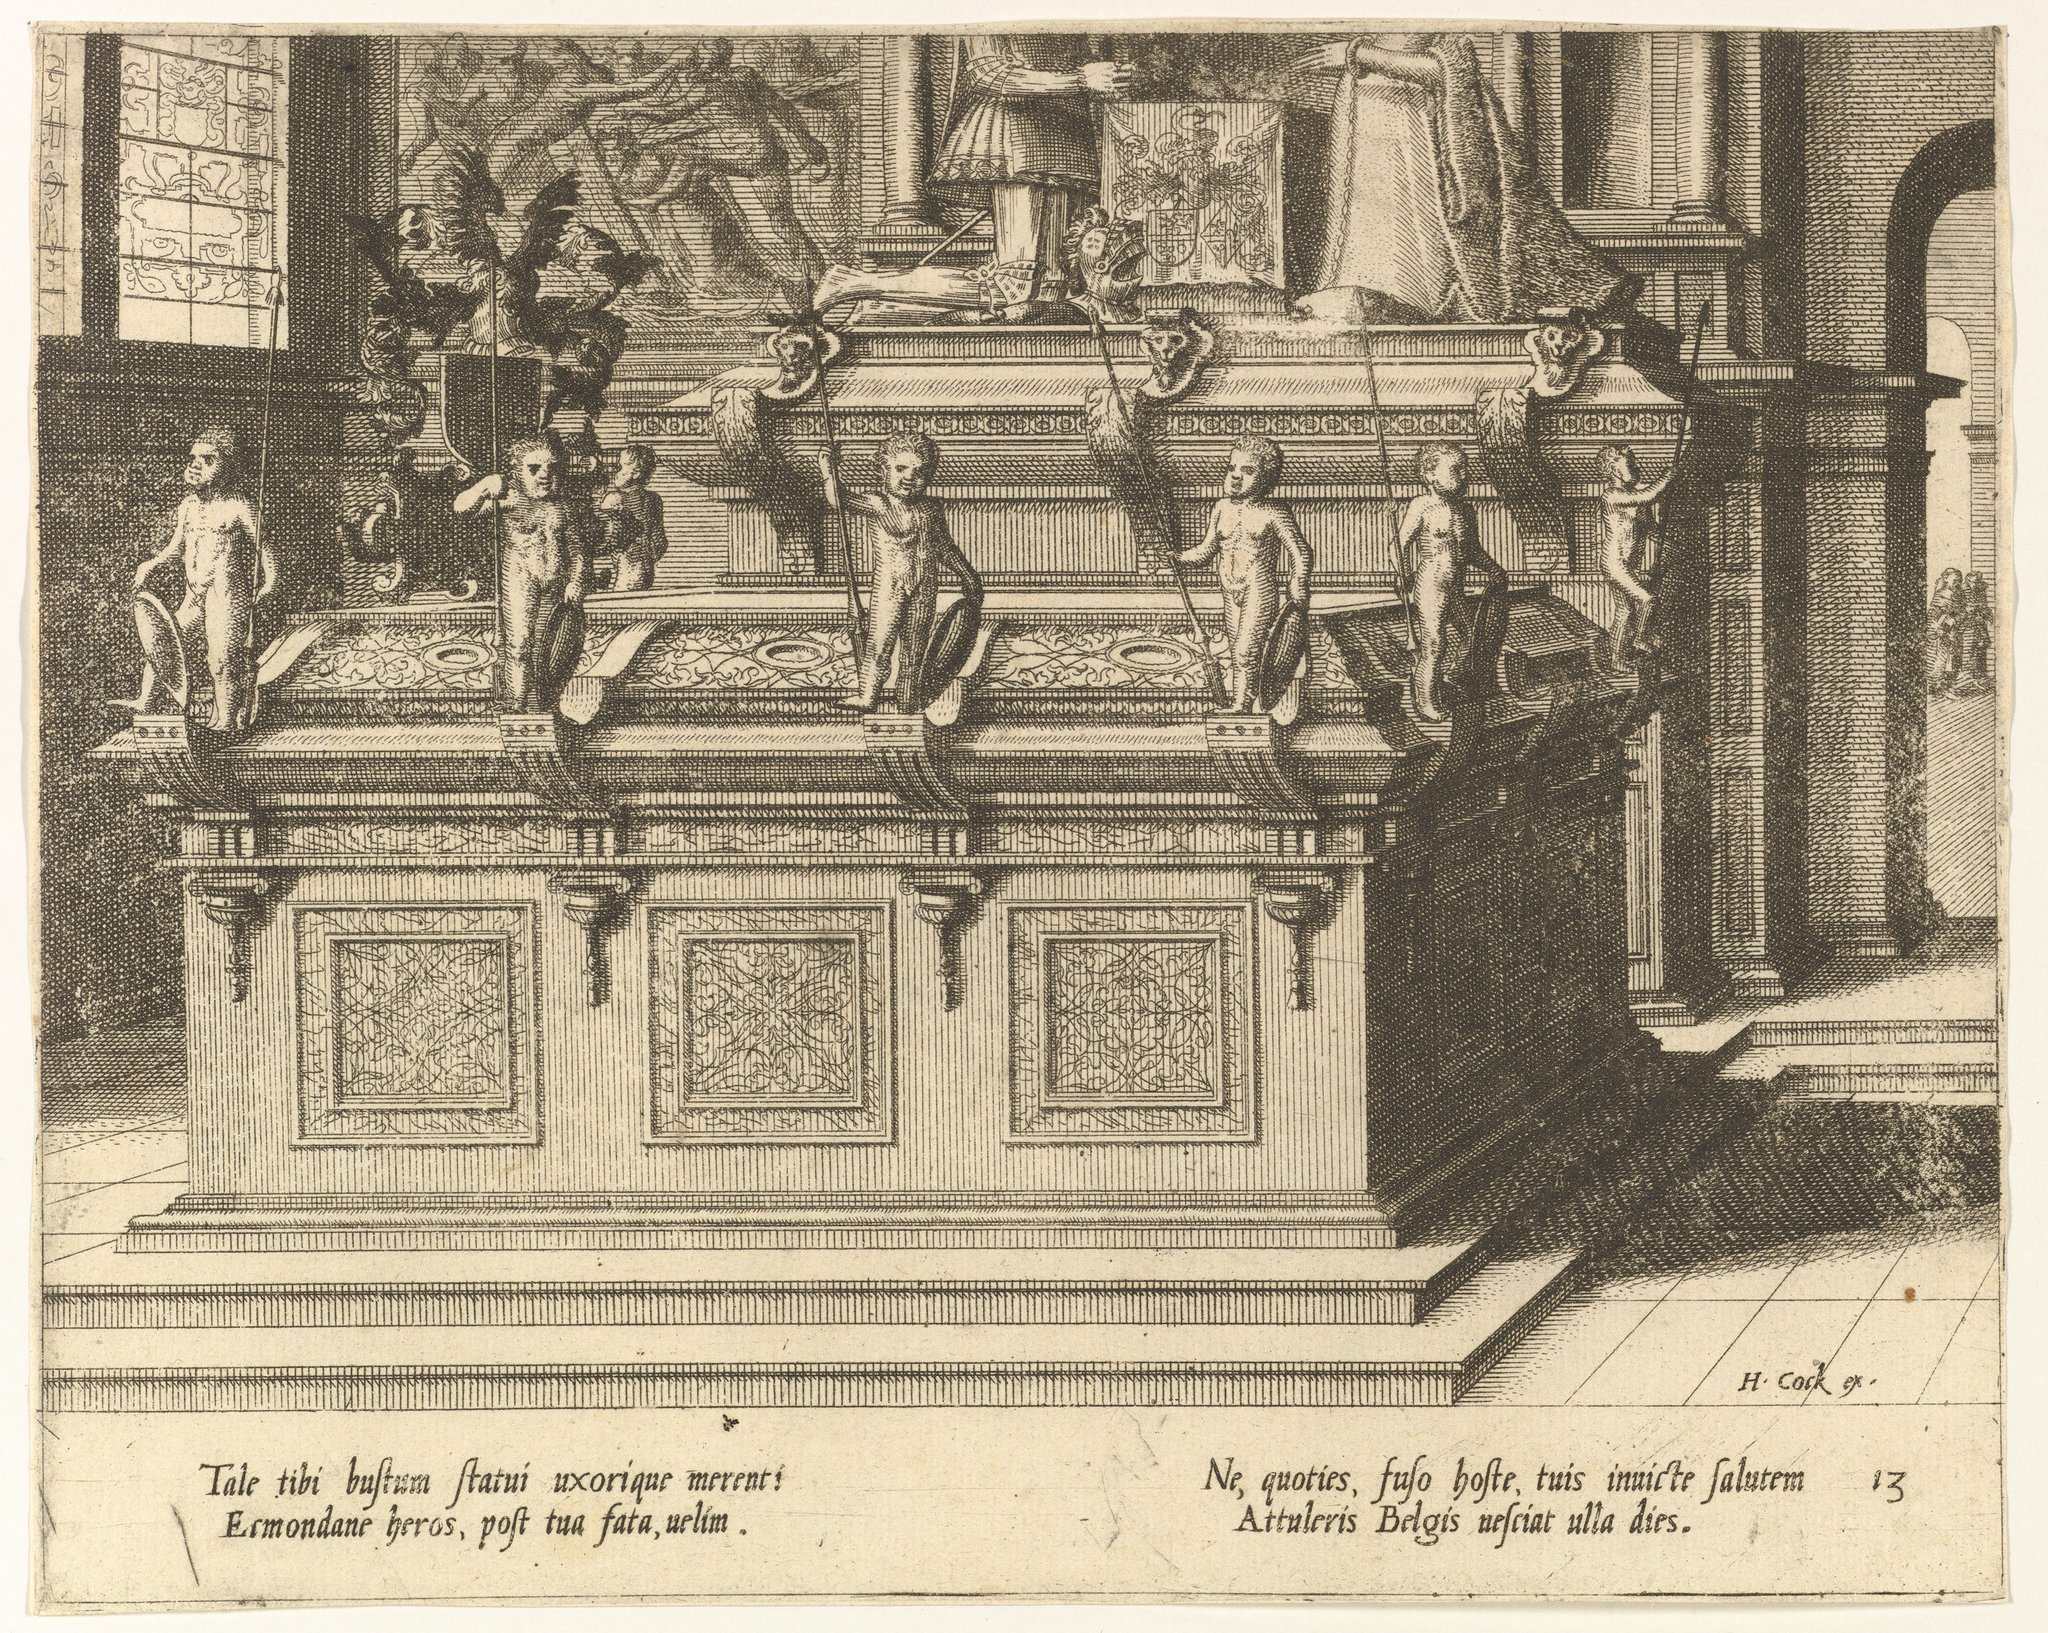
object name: collection ornament architecture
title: Cœnotaphiorum (13)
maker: hans vredeman de vries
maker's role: artist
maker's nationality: netherlandish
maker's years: 1527-1606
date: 1563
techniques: etching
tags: architecture,tombs,children